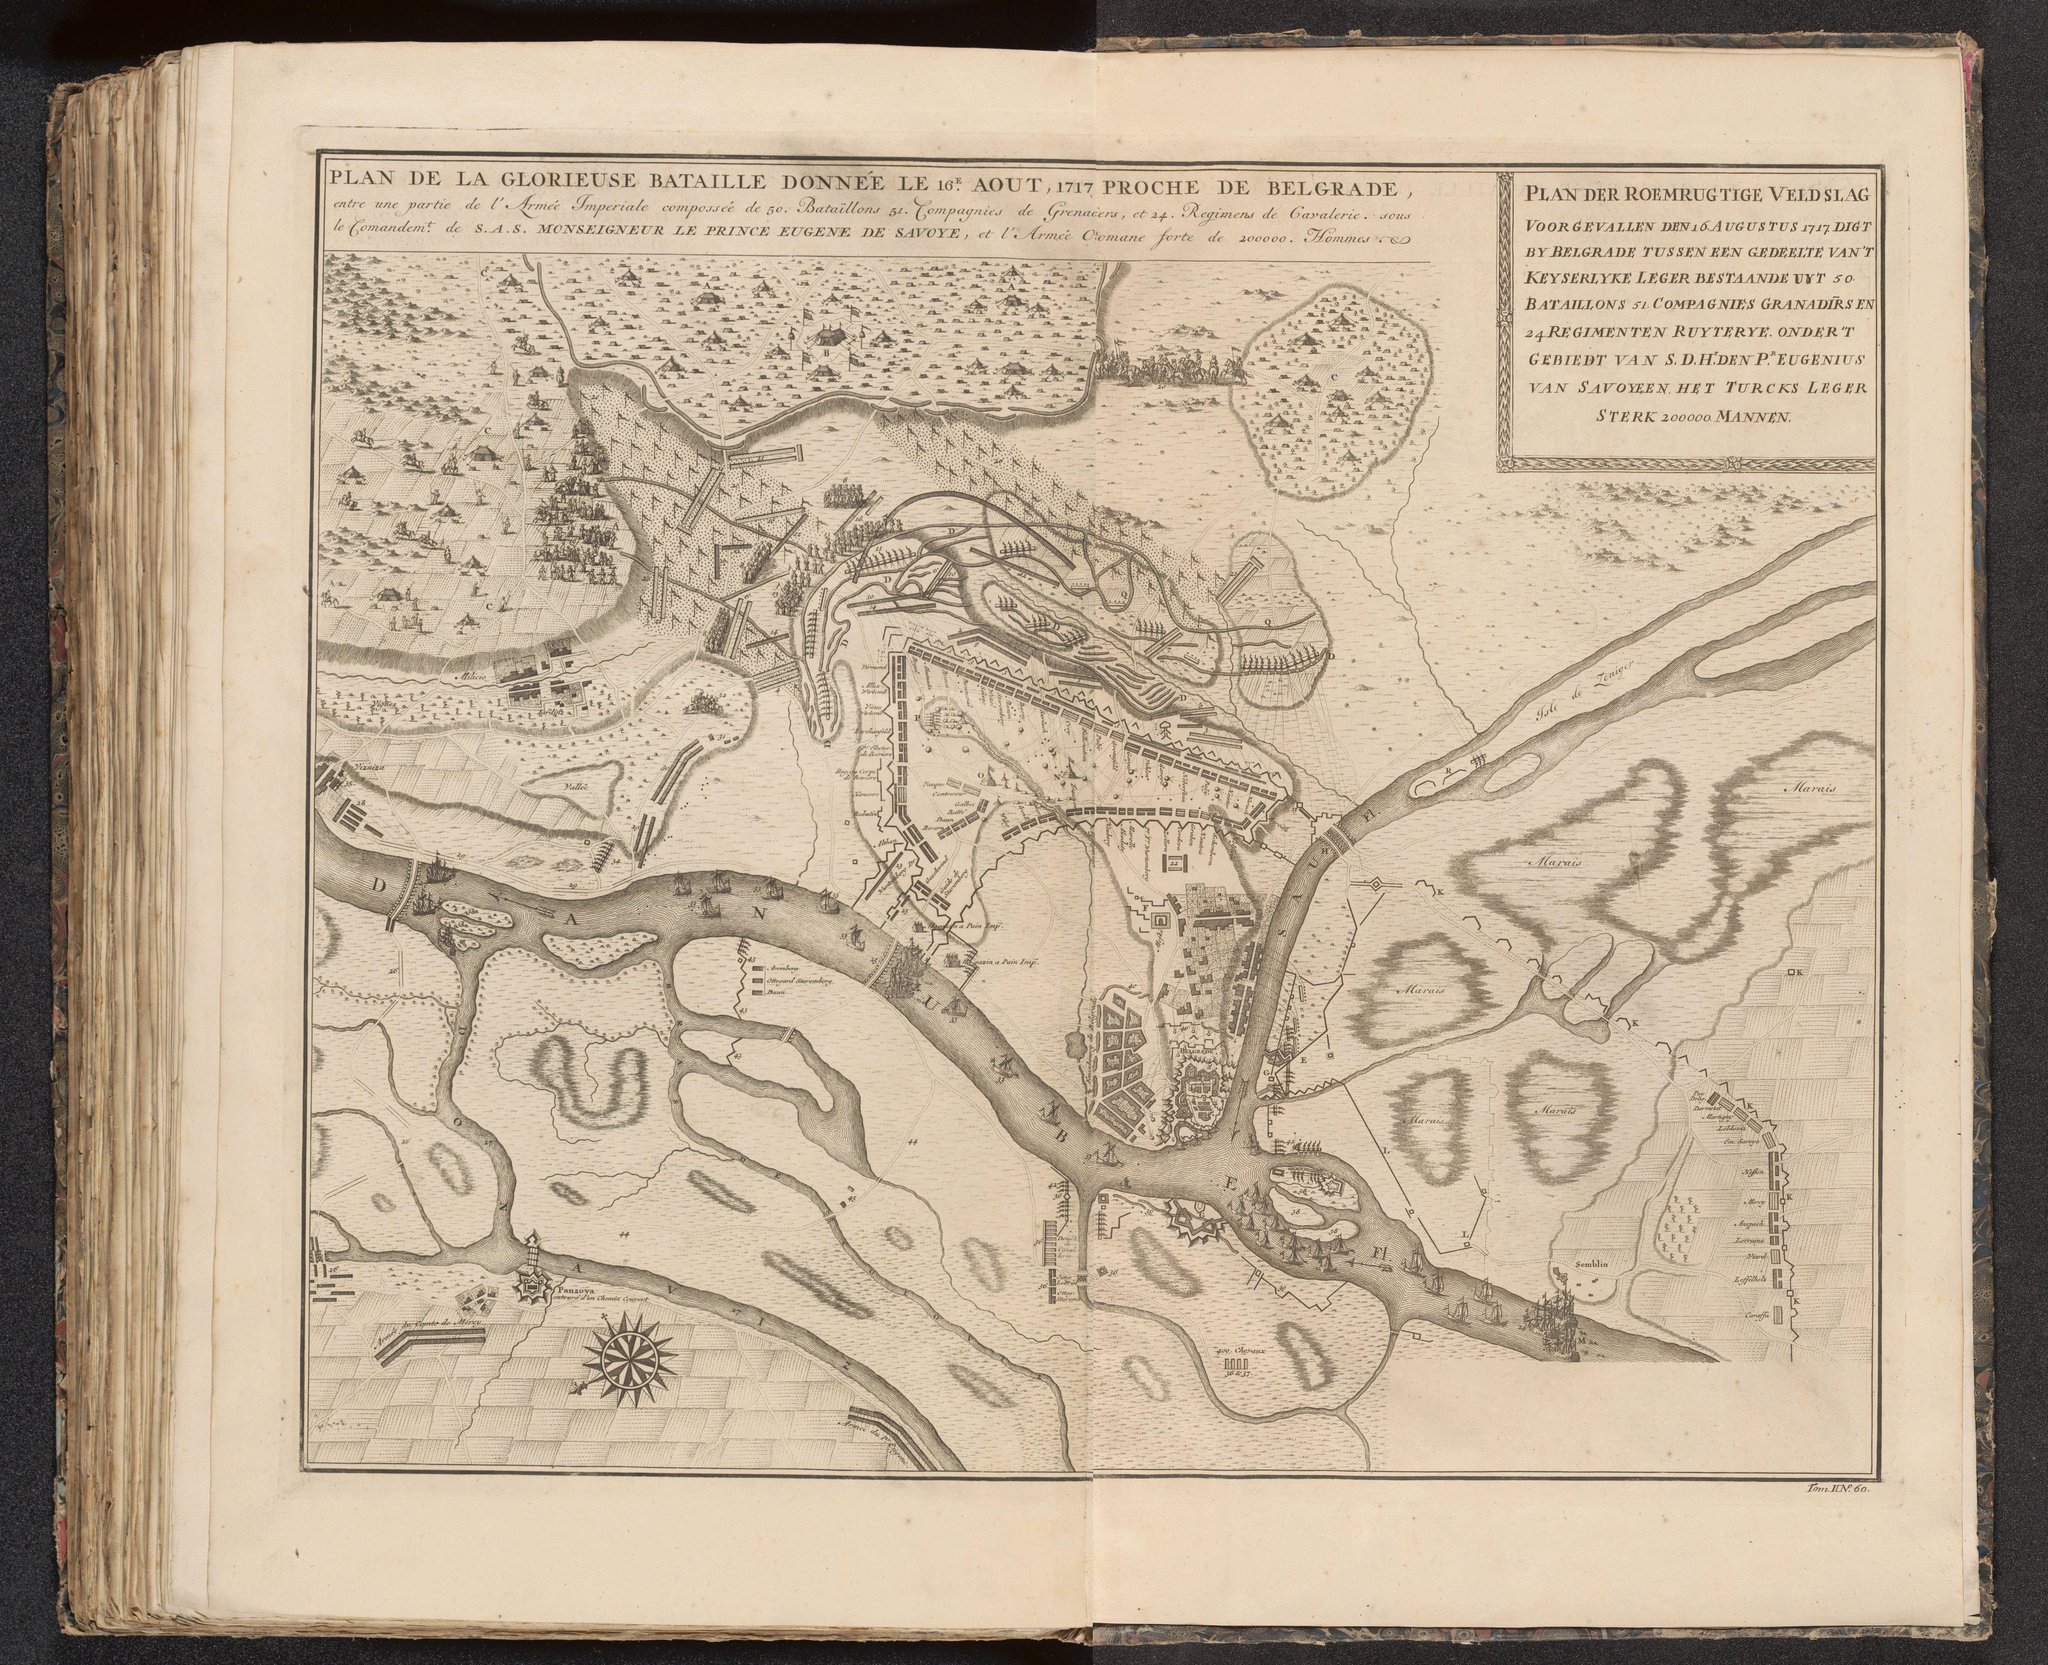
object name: print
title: Plan der Roemrugtige Veldslag voorgevallen den 16. Augustus 1717. digt by Belgrade tussen een gedeelte van 't Keyserlyke leger (...) onder 't gebiedt van (...) Pr. Eugenius van Savoyen, en het Turcks leger sterk 200.000 Mannen / Plan de la Glorieuse Bataille donnée le 16e Aout, 1717. Proche de Belgrade (...)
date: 1717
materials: paper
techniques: etching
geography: the hague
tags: paris, vienna, eugenius van savoye, maps of separate countries or regions, battle (+ land forces)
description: Kaart van de slag bij Belgrado. Verovering van Belgrado op de Turken door de keizerlijke troepen onder Eugenius van Savoye, 16 augustus 1717. Genummerd rechtsonder: Tom. II. No. 60. Illustratie in het tweede deel van : [Jean] du Mont, Oorlogskundige beschryving van de veldslagen en belegeringen, der drie ... wydvermaarde krygsoversten... den Prins Eugenius van Savoye, den ... Hertog van Marlborough, en den Prins van Oranje en Nassau-Vriesland, in de editie van 1729. Dit tweede deel is hoofdzakelijk gewijd aan de daden van de hertog van Marlborough en prins Johan Willem Friso.